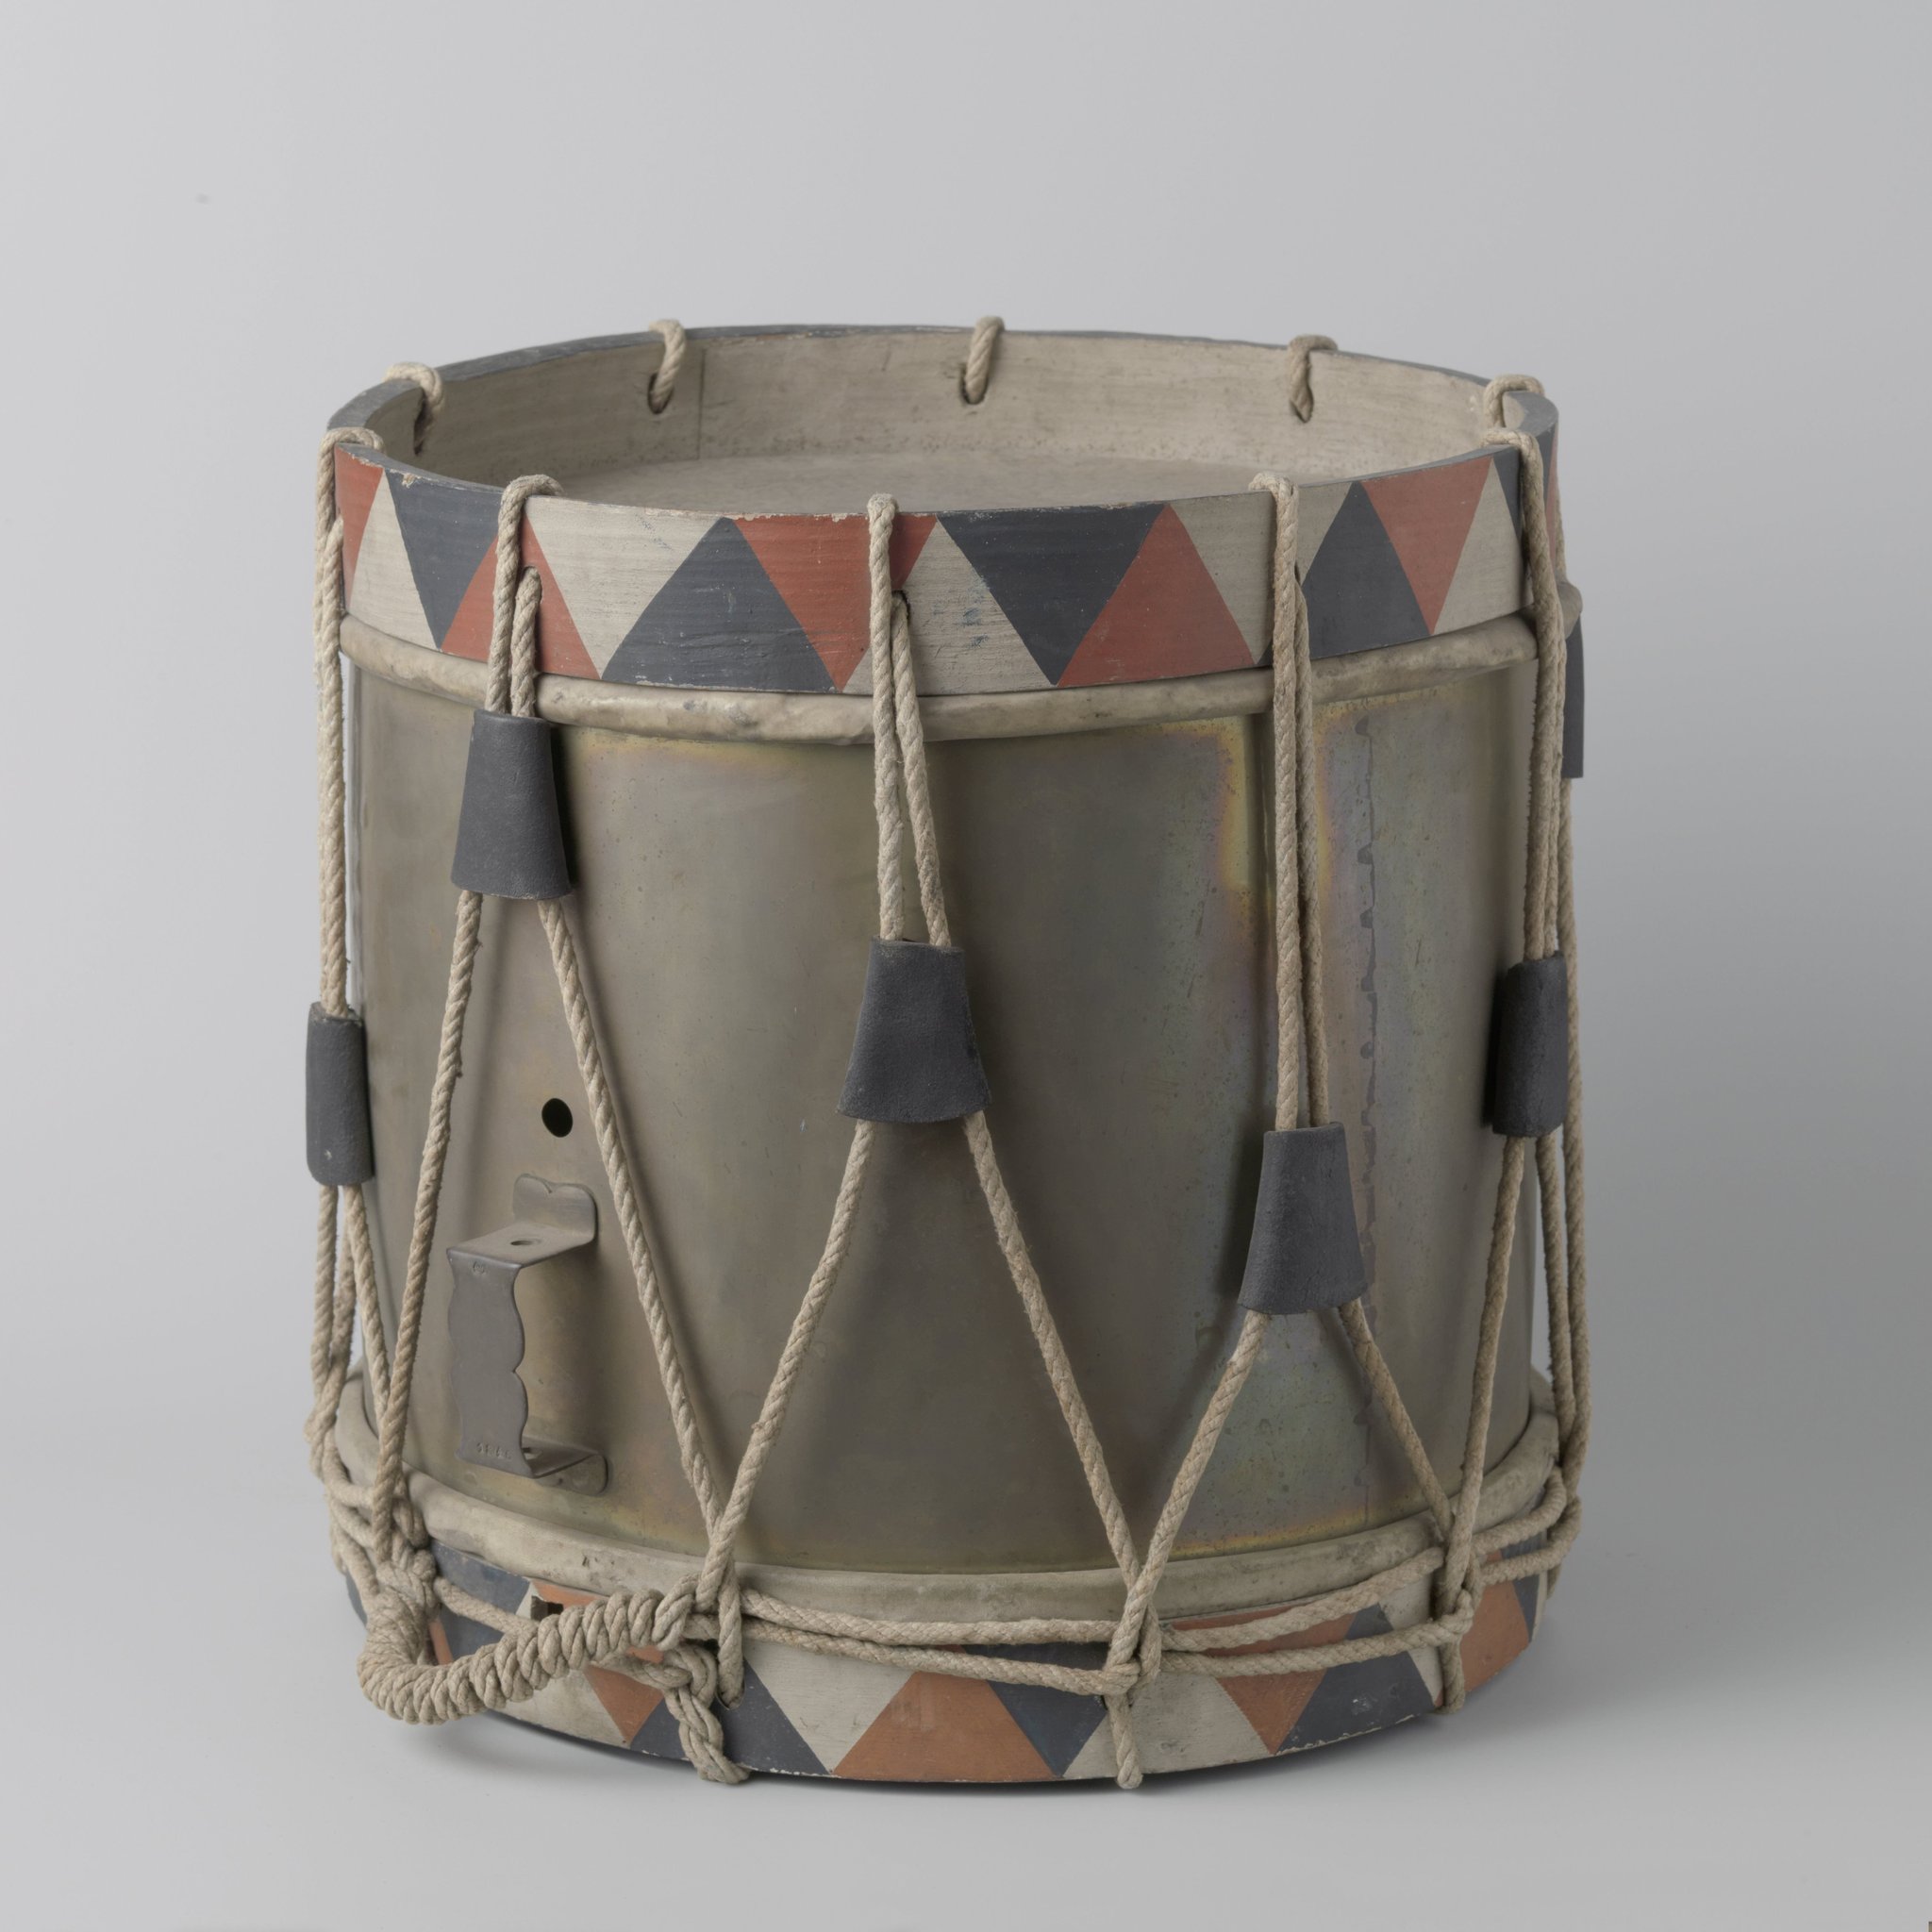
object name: percussion instrument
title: Drum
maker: Anonymous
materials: brass, leather, fiber, wood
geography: netherlands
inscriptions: inscription: ‘1846-41’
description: Music has always been a crucial element of public celebrations, such as military parades, coronations, royal weddings, and funerals, adding grandeur to the solemnity of the occasion. Musical ensembles entrusted with performing music at these events have existed in Europe since the Middle Ages. This display highlights various marching bands and their musical instruments dating from the 16th to the 19th century.